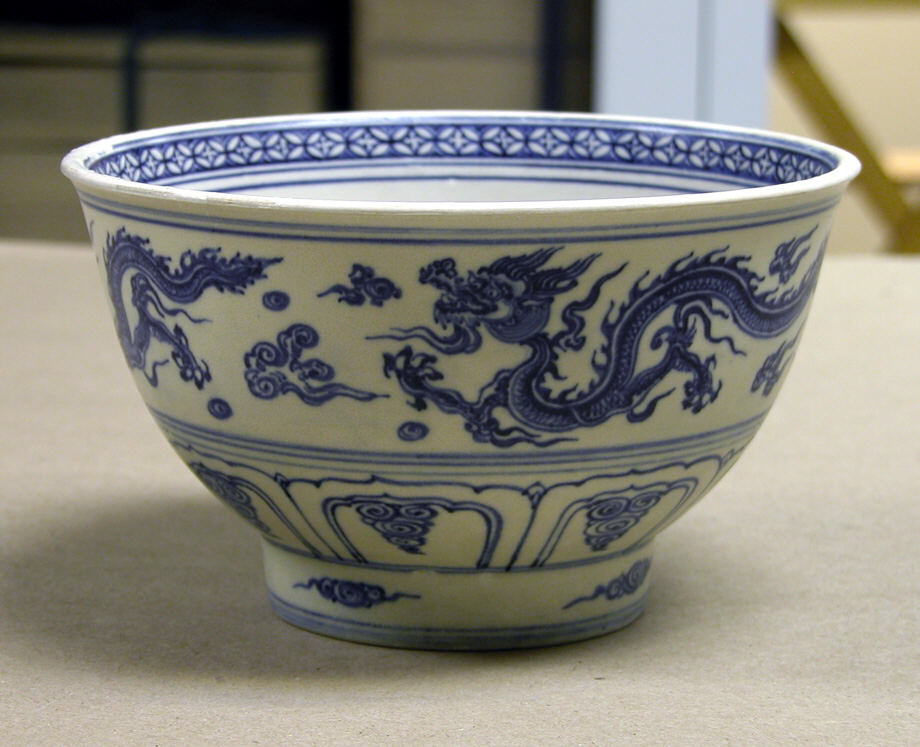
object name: bowl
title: Bowl Decorated with Dragons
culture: vietnamese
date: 1401-1500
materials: cobalt, stoneware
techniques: underglaze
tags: dragons